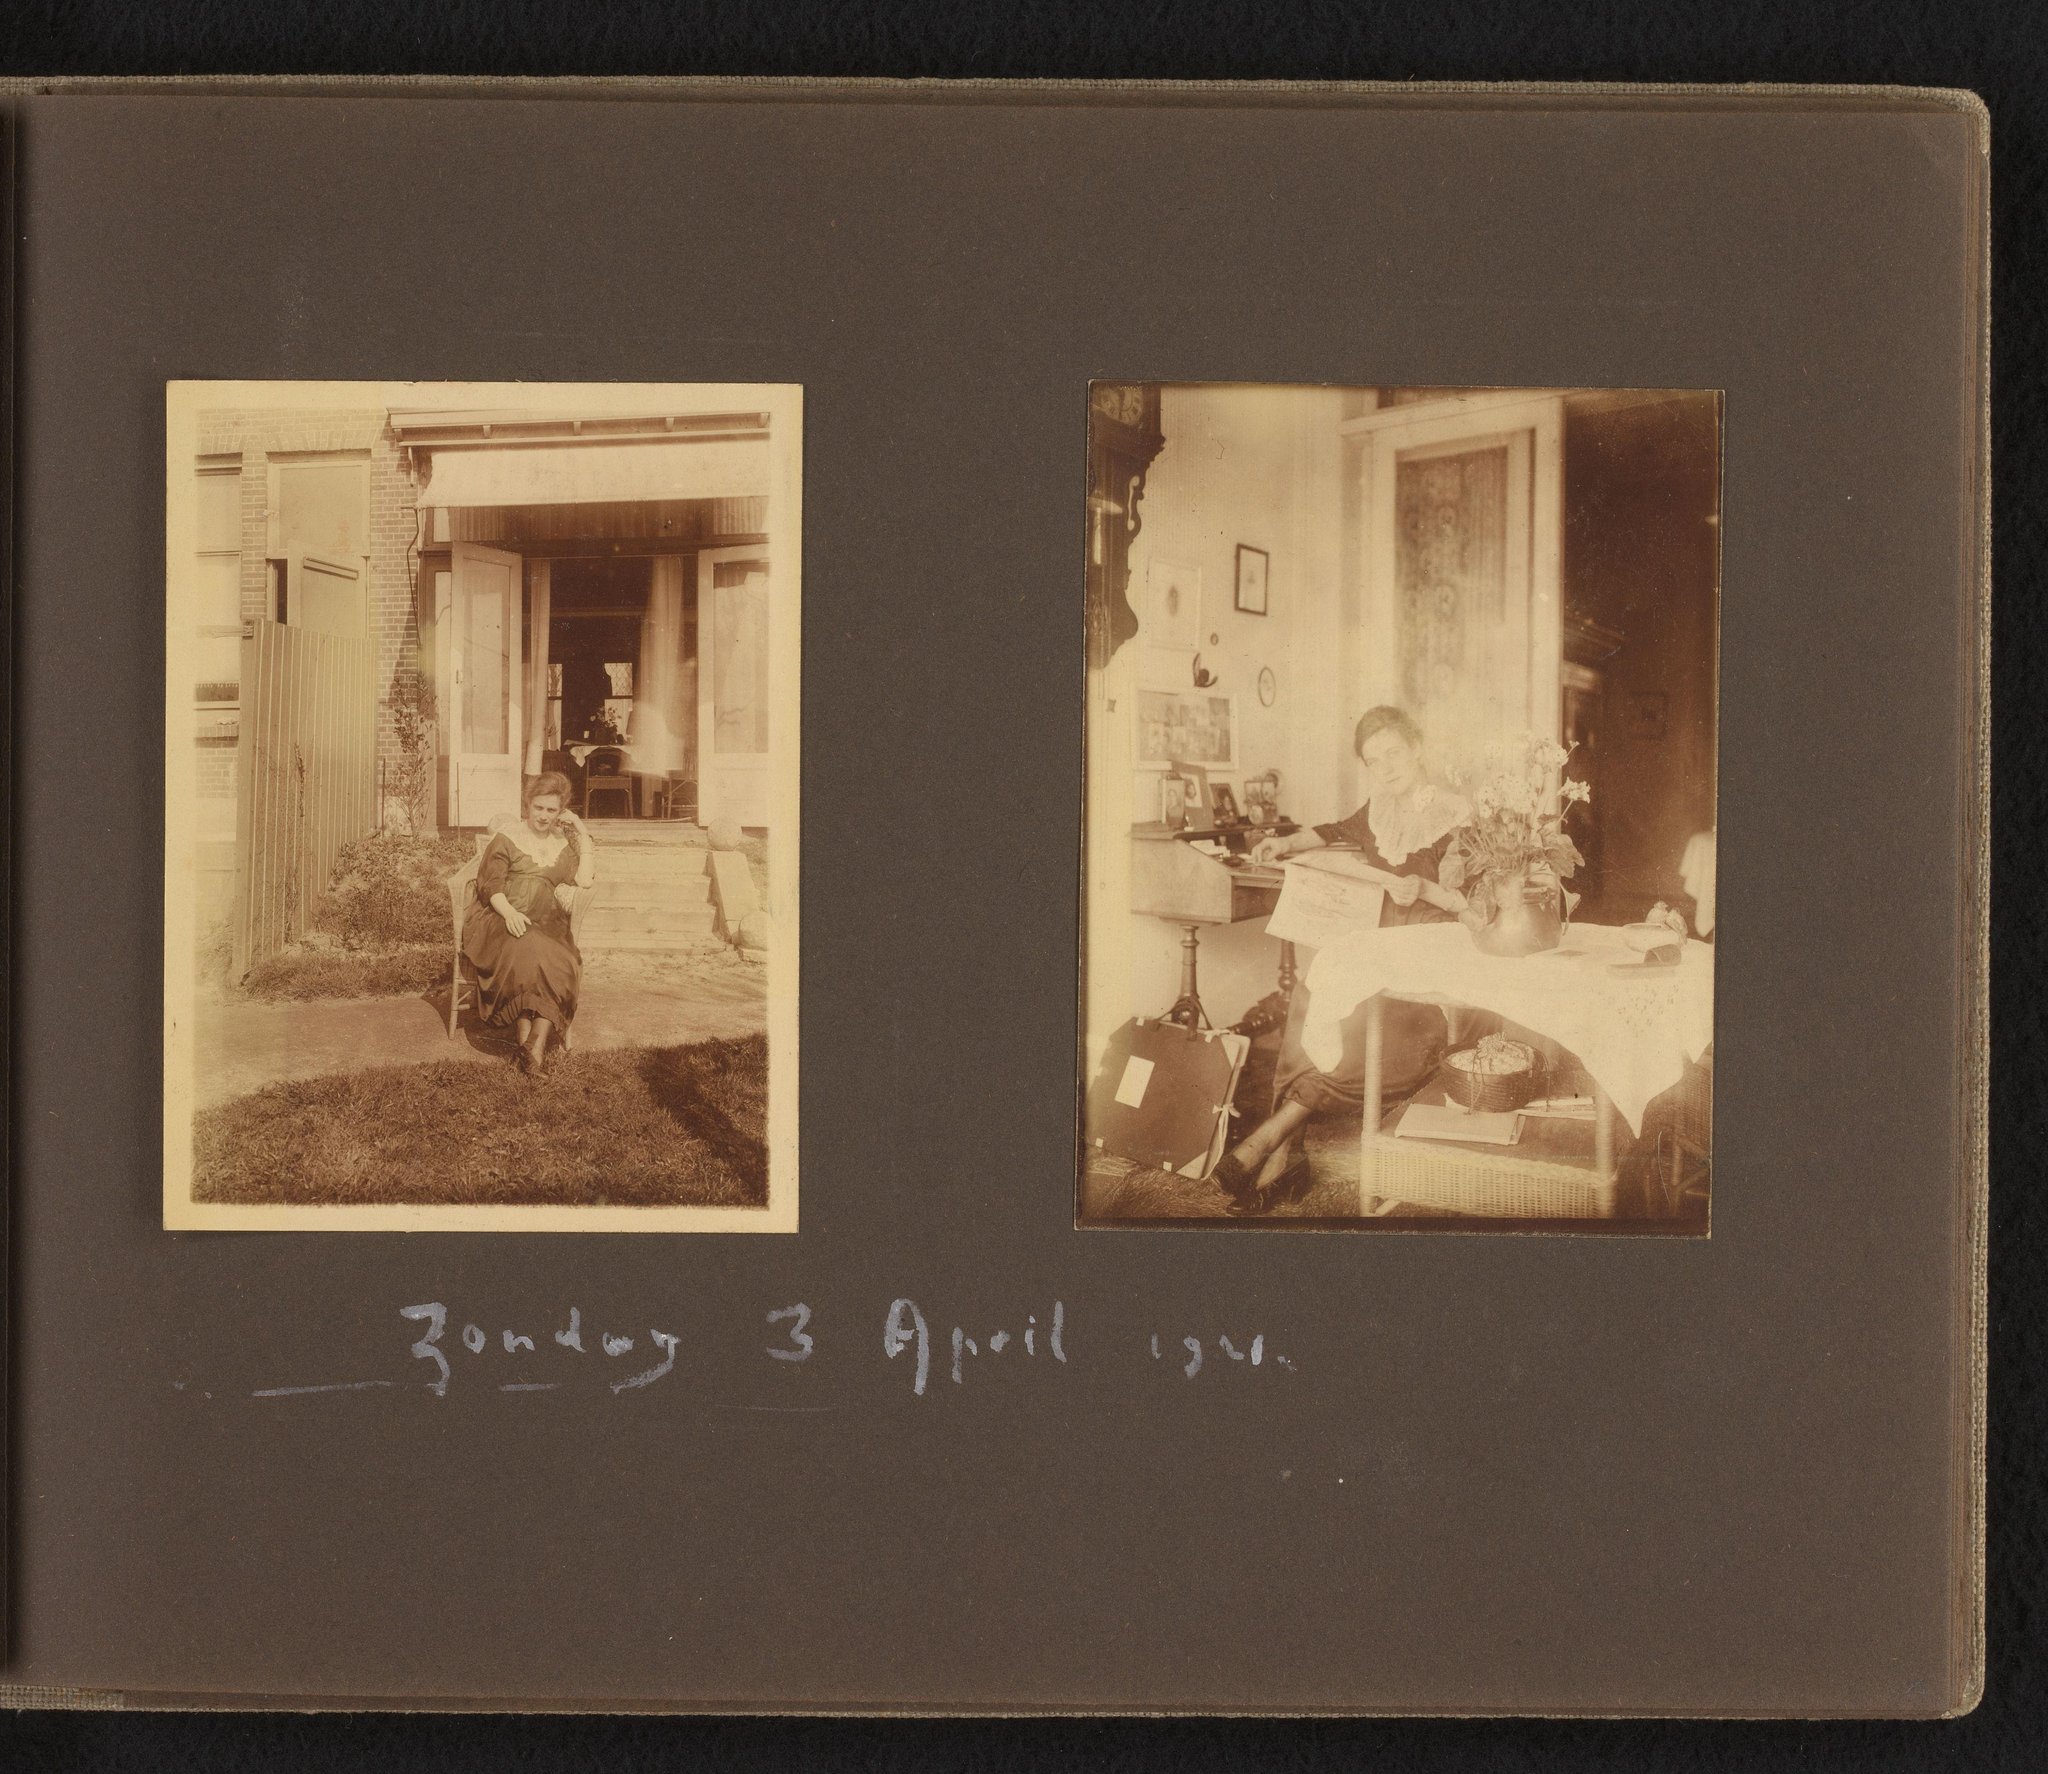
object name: photograph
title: Johanna (Hans) de Jong in de woning en de tuin van de Leidsestraatweg 36 te Oegstgeest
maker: frederik stokhuyzen (frits)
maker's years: 1890-1976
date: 1921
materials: paper, cardboard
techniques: collodion silver print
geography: oegstgeest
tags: historical persons - bb - woman, garden, interior of the house